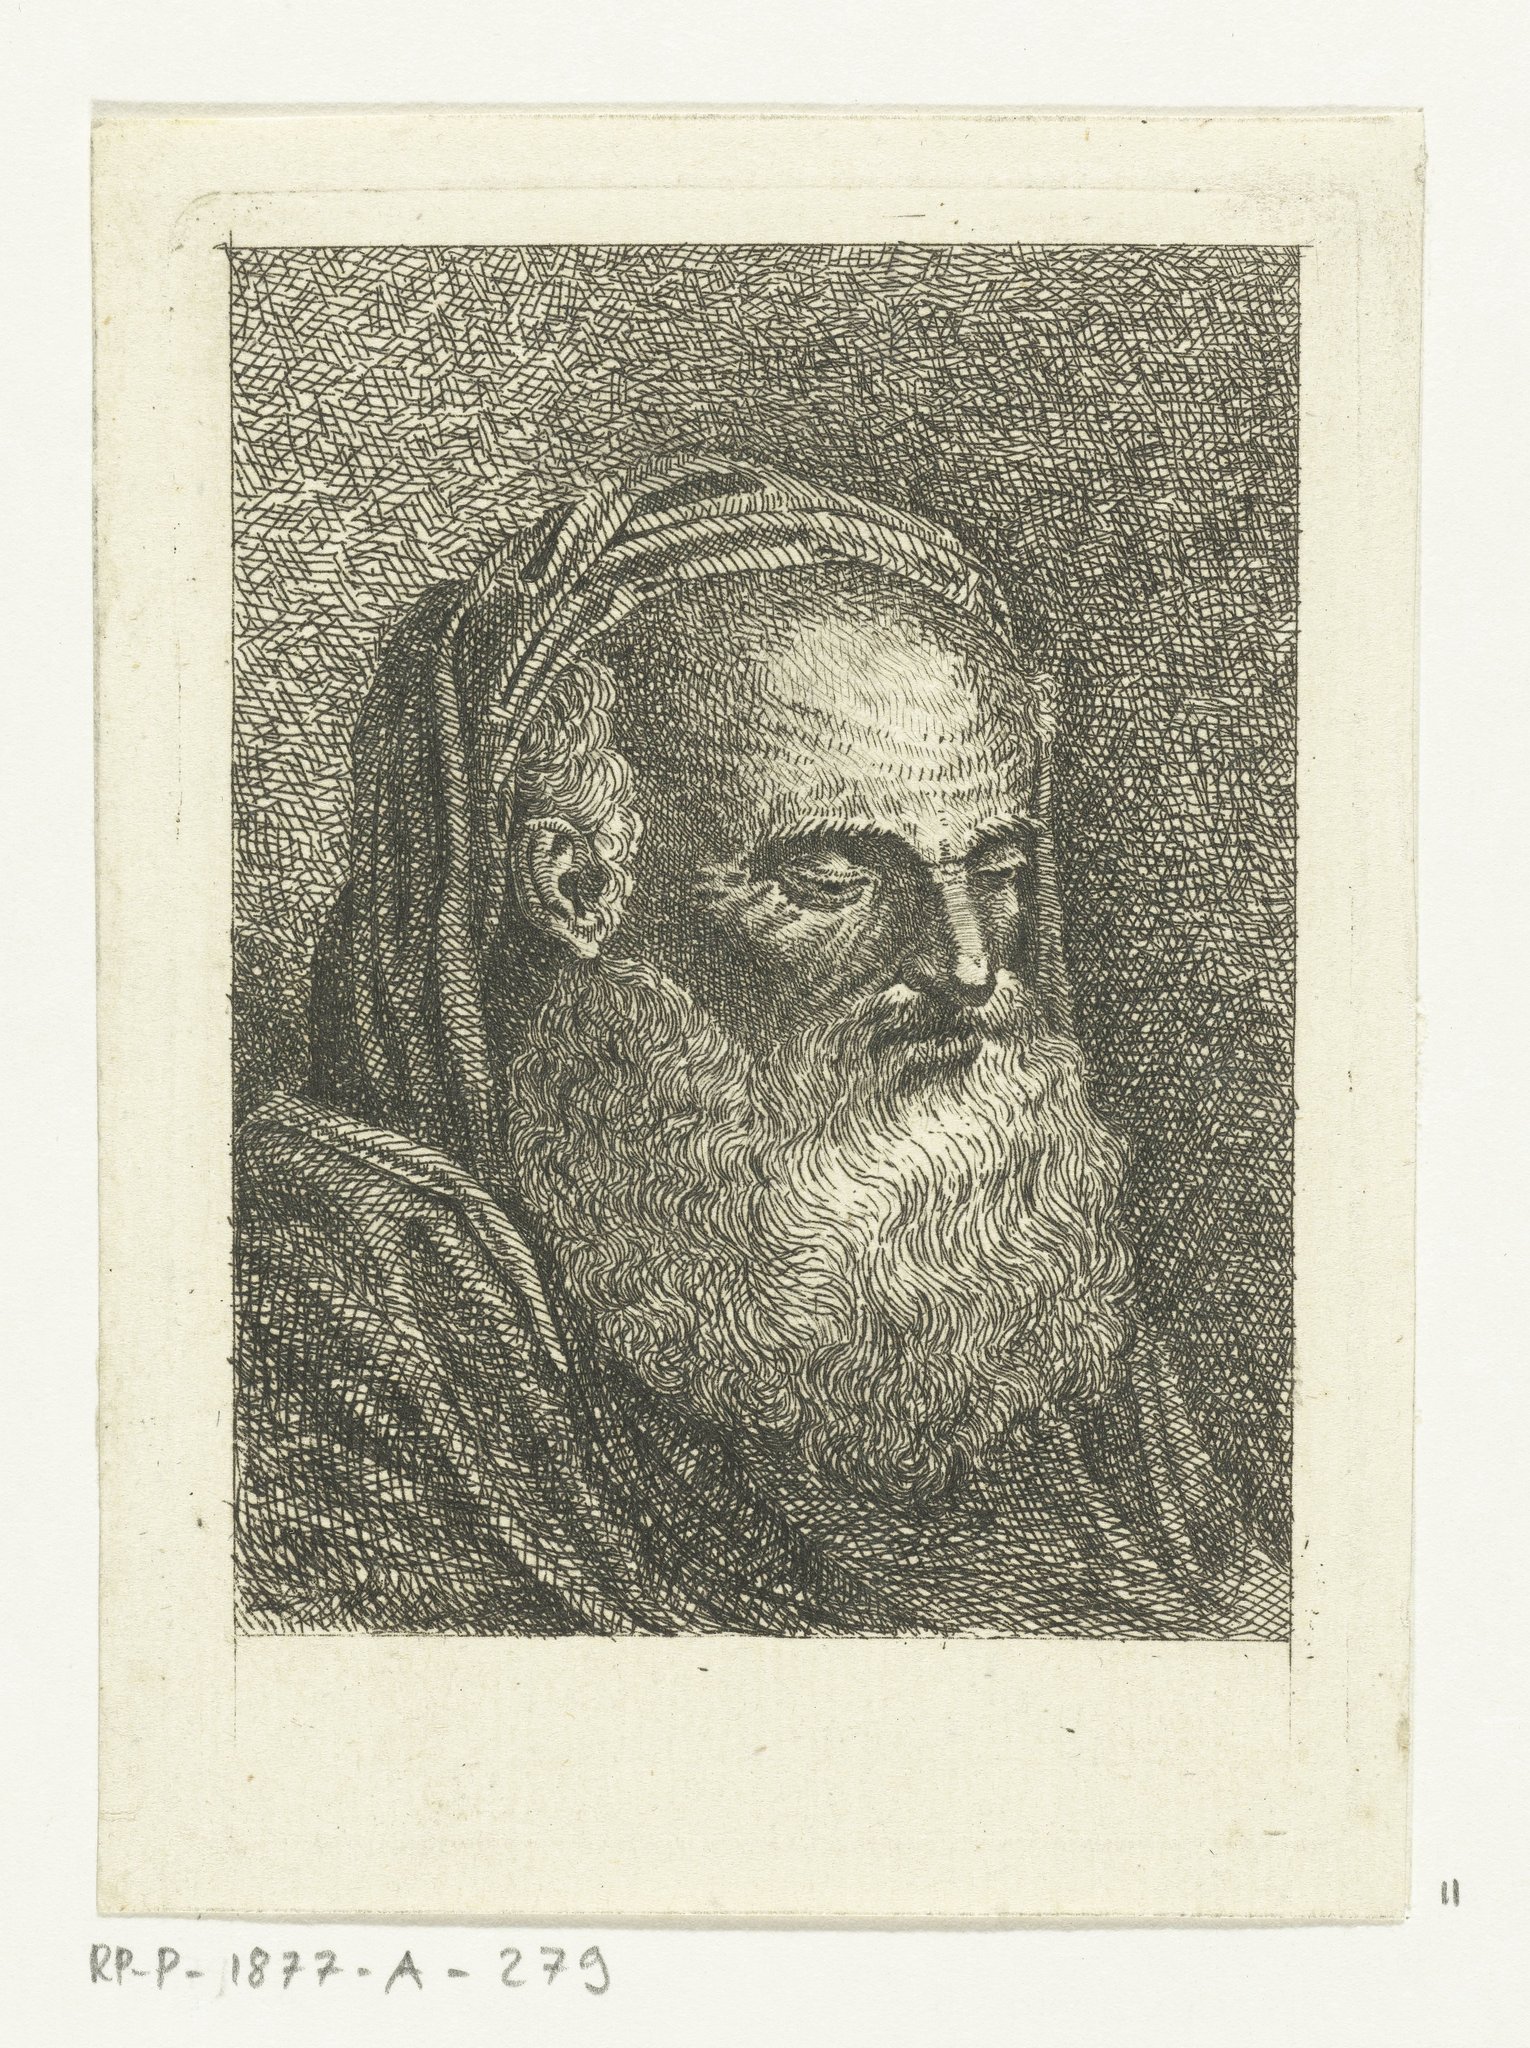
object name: print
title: Borstbeeld van een oude man met witte baard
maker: anthonie van den bos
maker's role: draughtsman, print maker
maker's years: 1763-1838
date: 1778-1838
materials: paper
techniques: etching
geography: netherlands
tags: old man (+ three-quarter view)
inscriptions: collector's mark: Lugt 2228